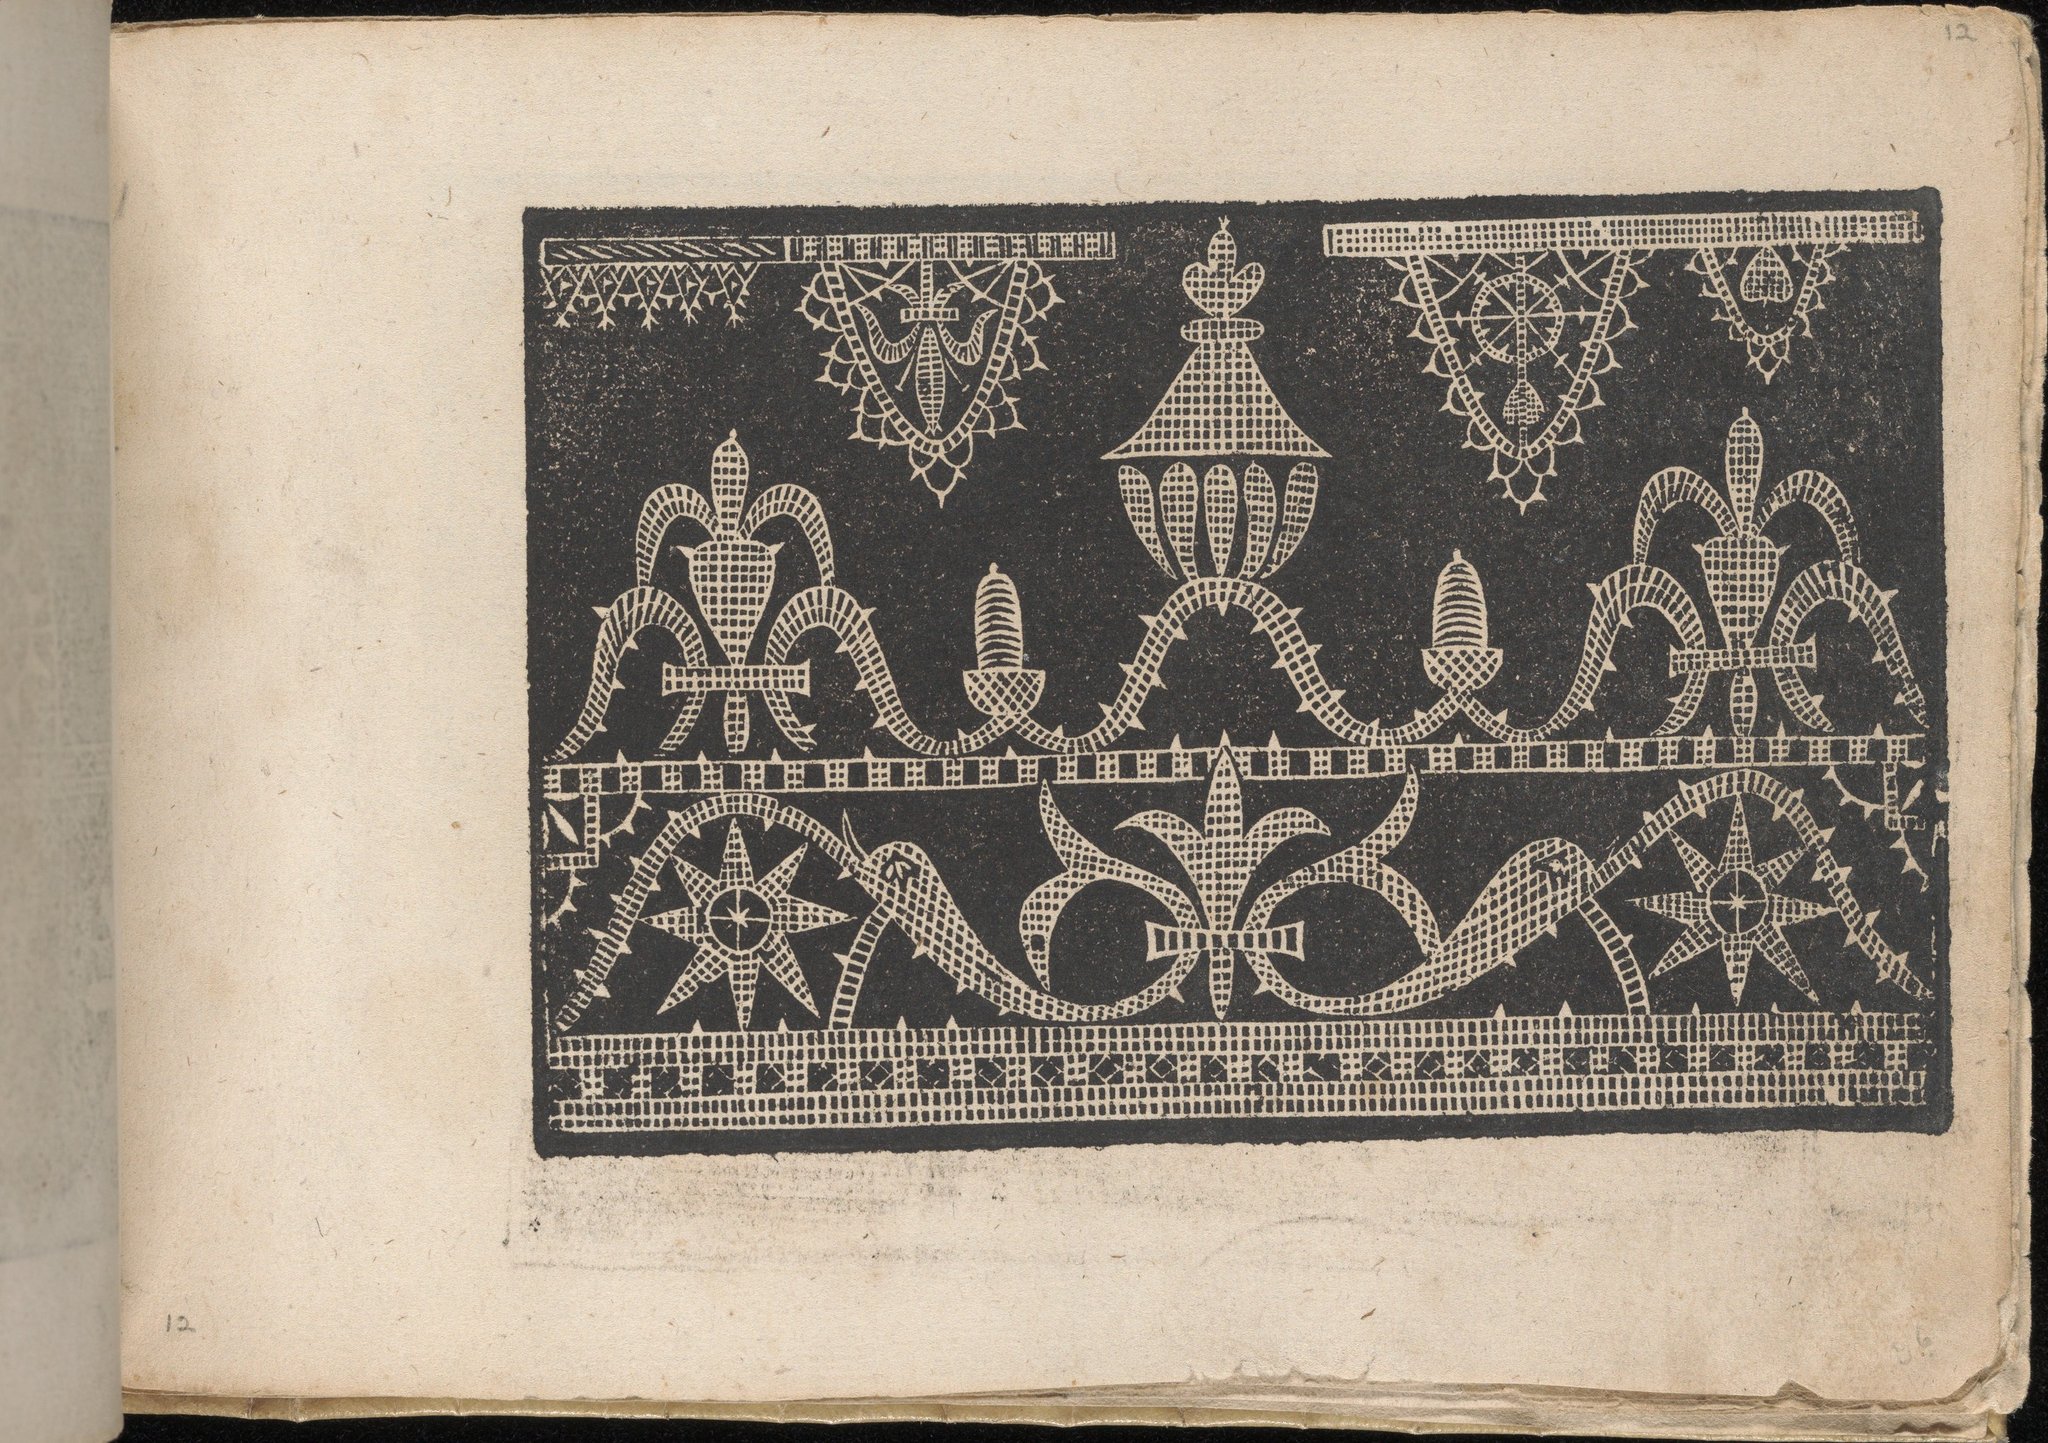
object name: book print ornament archiecture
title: Fiori di Ricami Nuovamente Posti in Luce, page 12 (recto)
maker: matteo florimi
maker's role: designer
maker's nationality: italian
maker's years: 1581-1613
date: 1591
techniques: woodcut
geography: italy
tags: flowers,acorns